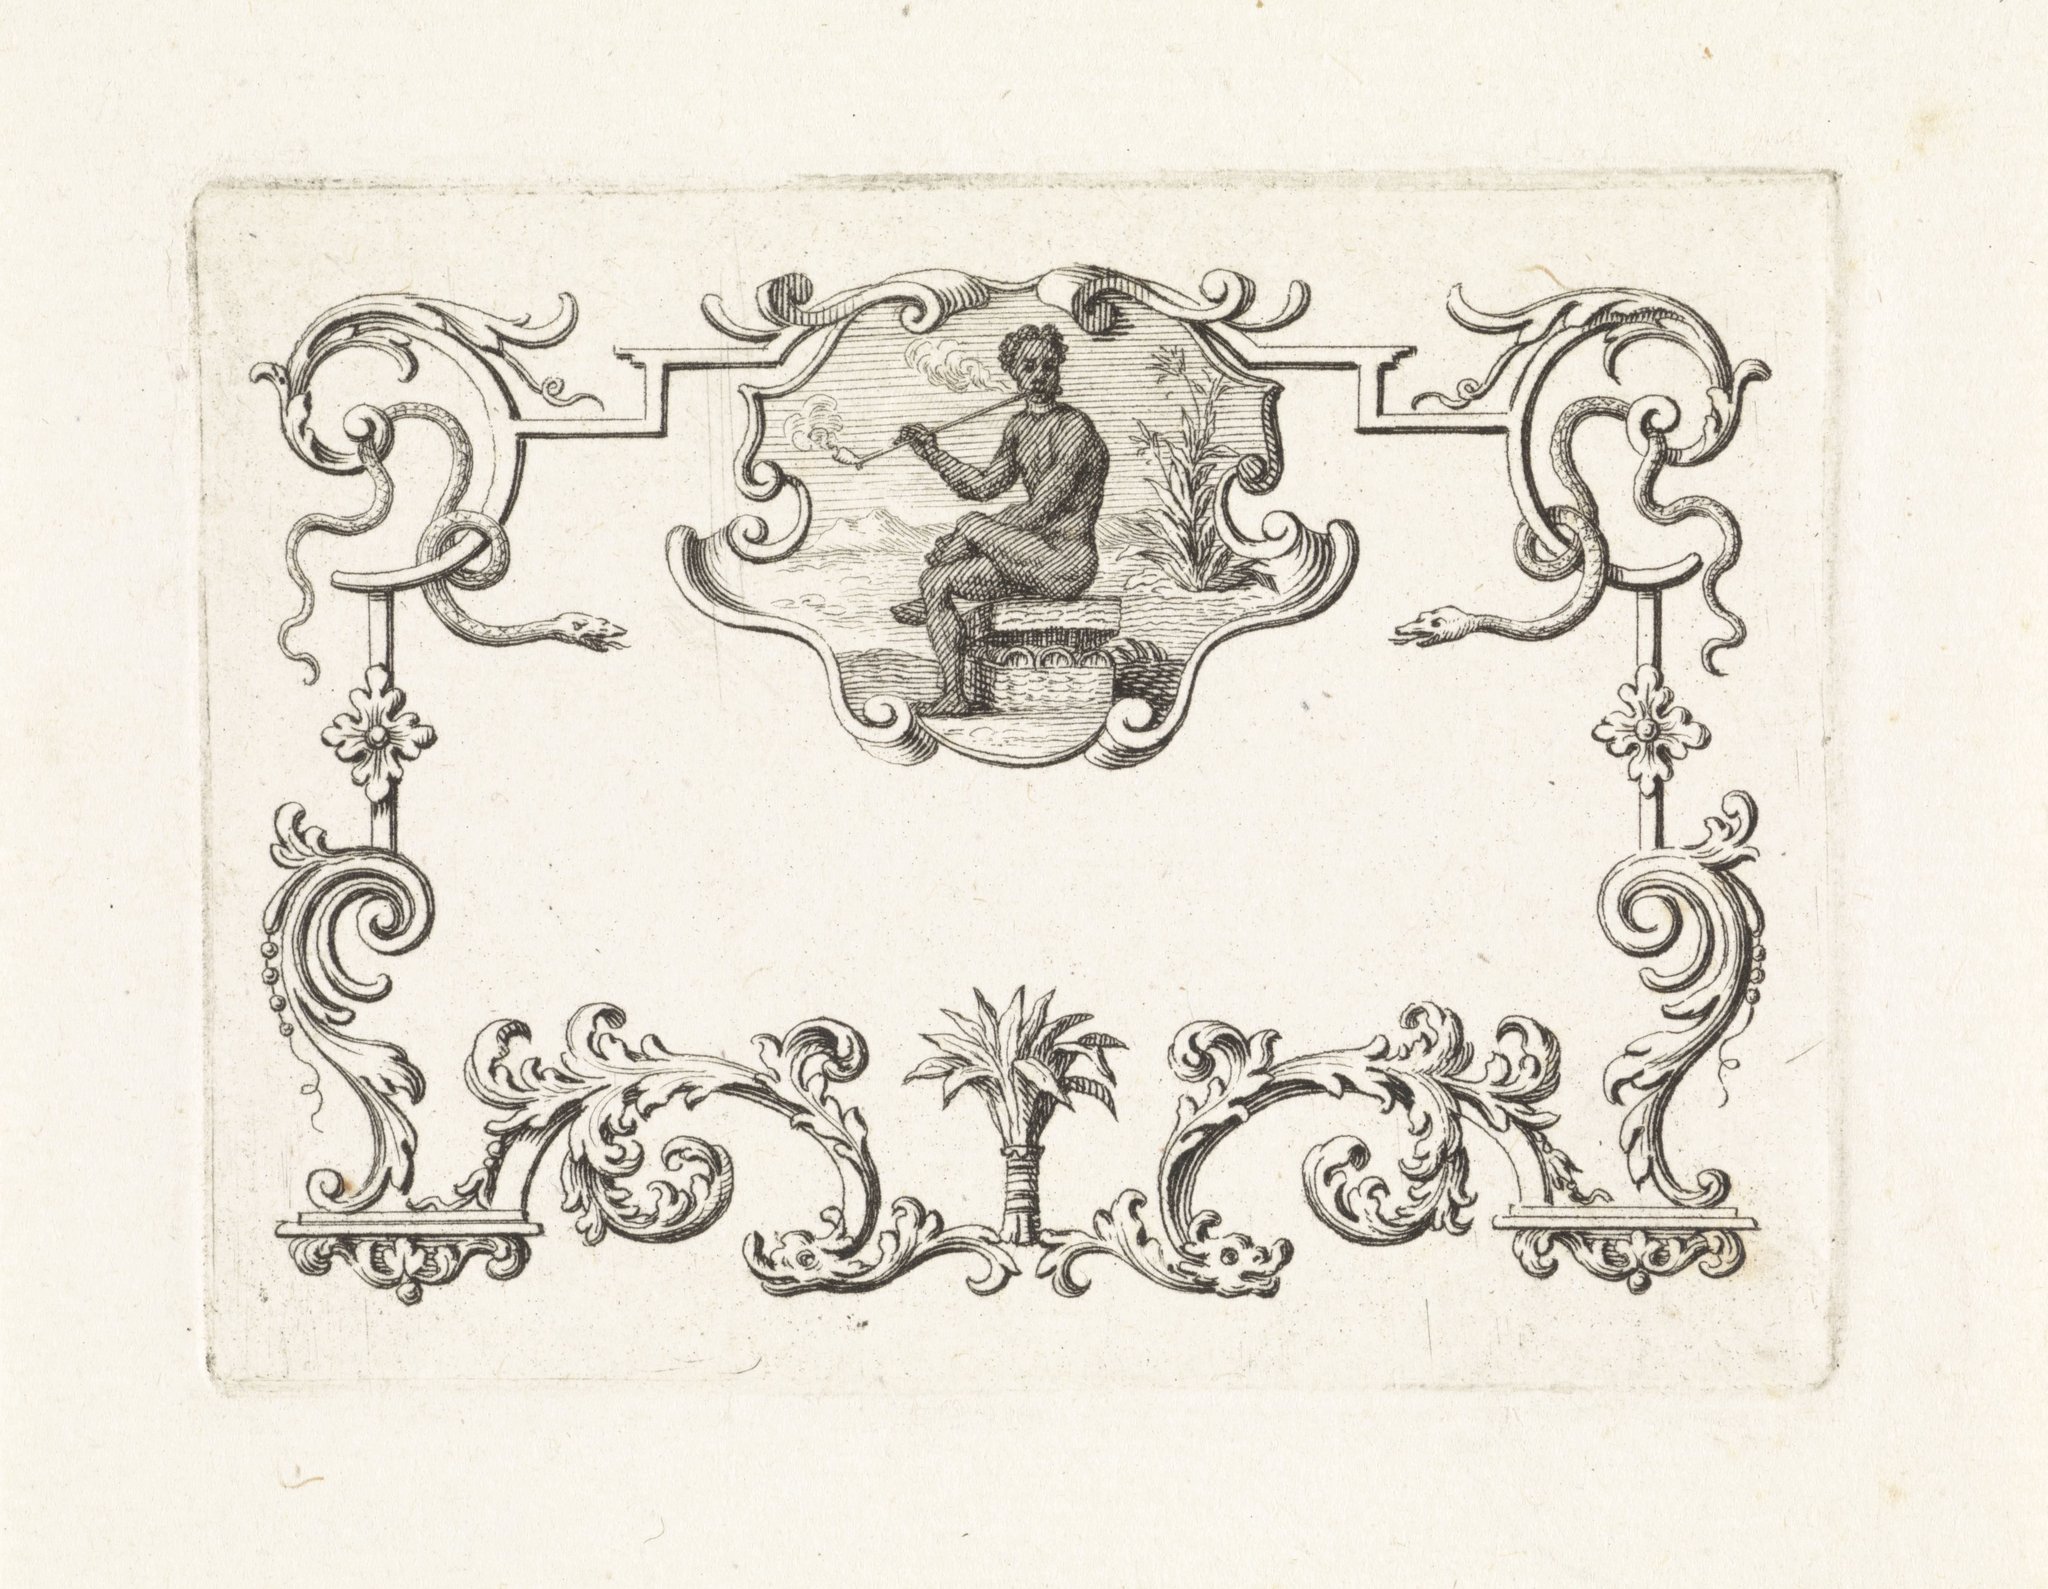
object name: ornament print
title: Pijprokende zwarte man in een lijst met ornamenten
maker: Anonymous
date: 1683-1783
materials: paper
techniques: engraving, etching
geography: netherlands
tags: ornaments ~ art, pipe ~ tobacco, americans with african roots, african-americans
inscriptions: collector's mark: Lugt 240